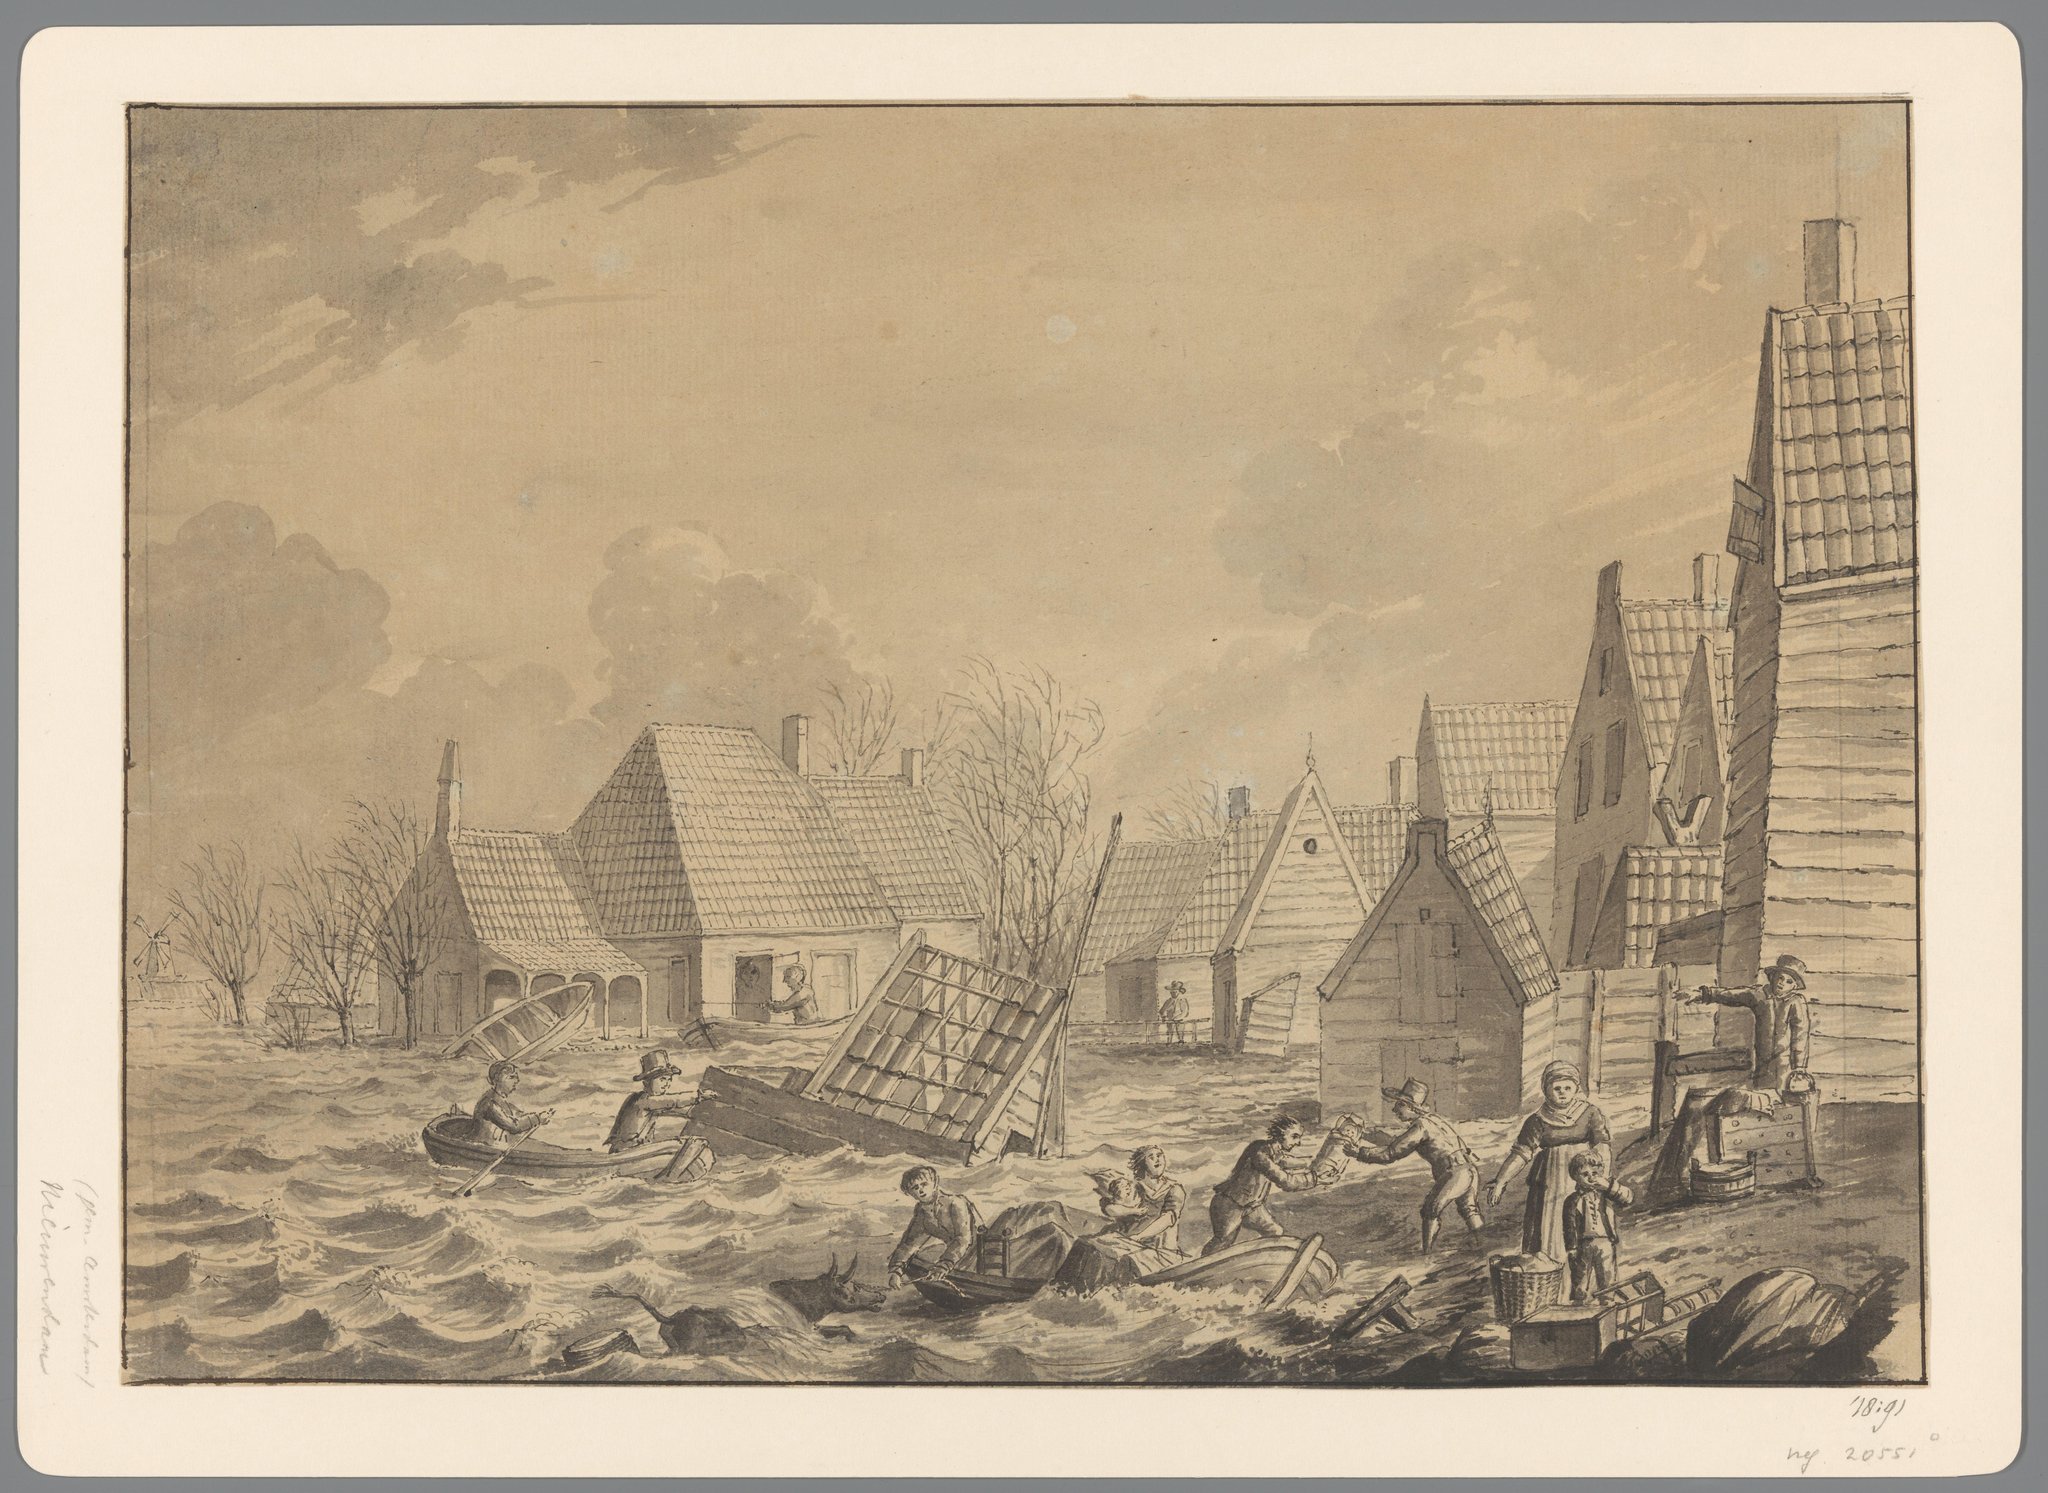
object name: drawing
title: Gezicht op Nieuwendam tijdens de watersnood in 1825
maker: Anonymous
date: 1825-1830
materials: ink, paper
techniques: brush, pen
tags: rescue work during a flood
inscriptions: collector's mark: Lugt 2228, watermark